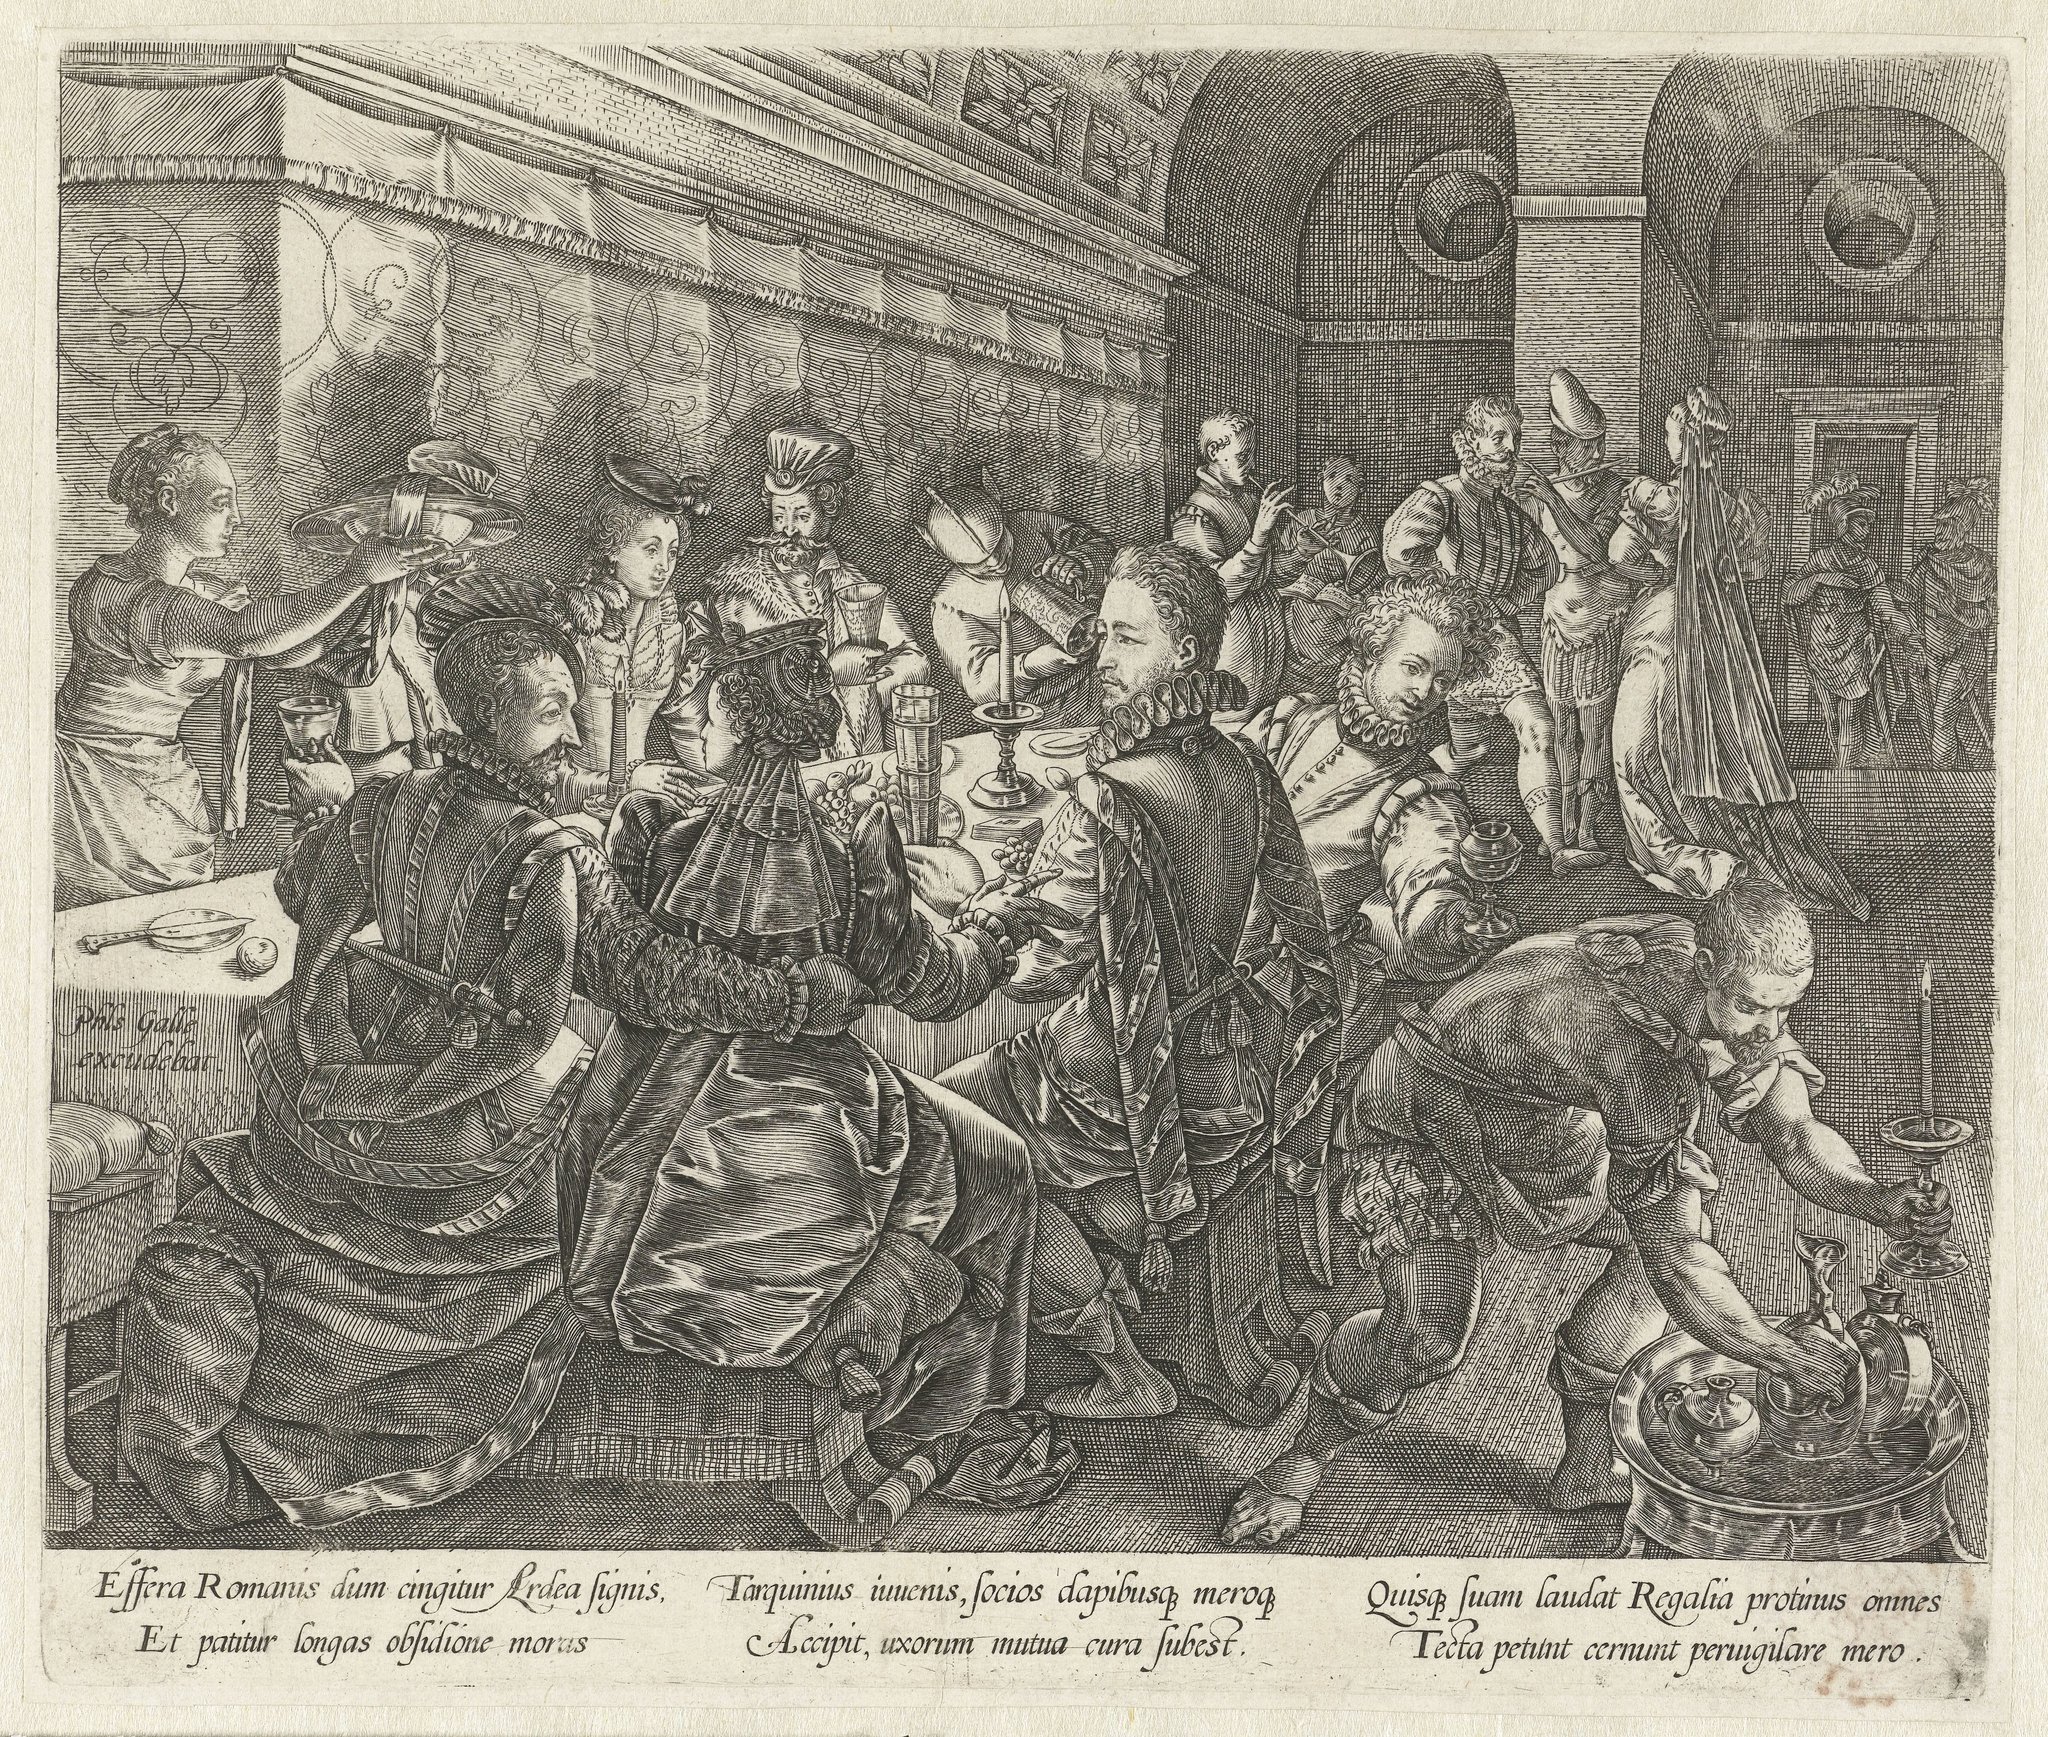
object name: print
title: De geschiedenis van Lucretia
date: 1578-1580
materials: paper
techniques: engraving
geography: haarlem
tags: (story of) lucretia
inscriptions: address: ‘Phls Galle excudebat.’, collector's mark: Lugt 240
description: Een groep feestelijk geklede mannen en vrouwen gebruikt de maaltijd in een zaal. Op de achtergrond een aantal muzikanten. Onder de voorstelling zes regels Latijn. Deze prent is onderdeel van een serie van vier prenten die de geschiedenis van Lucretia verbeelden.